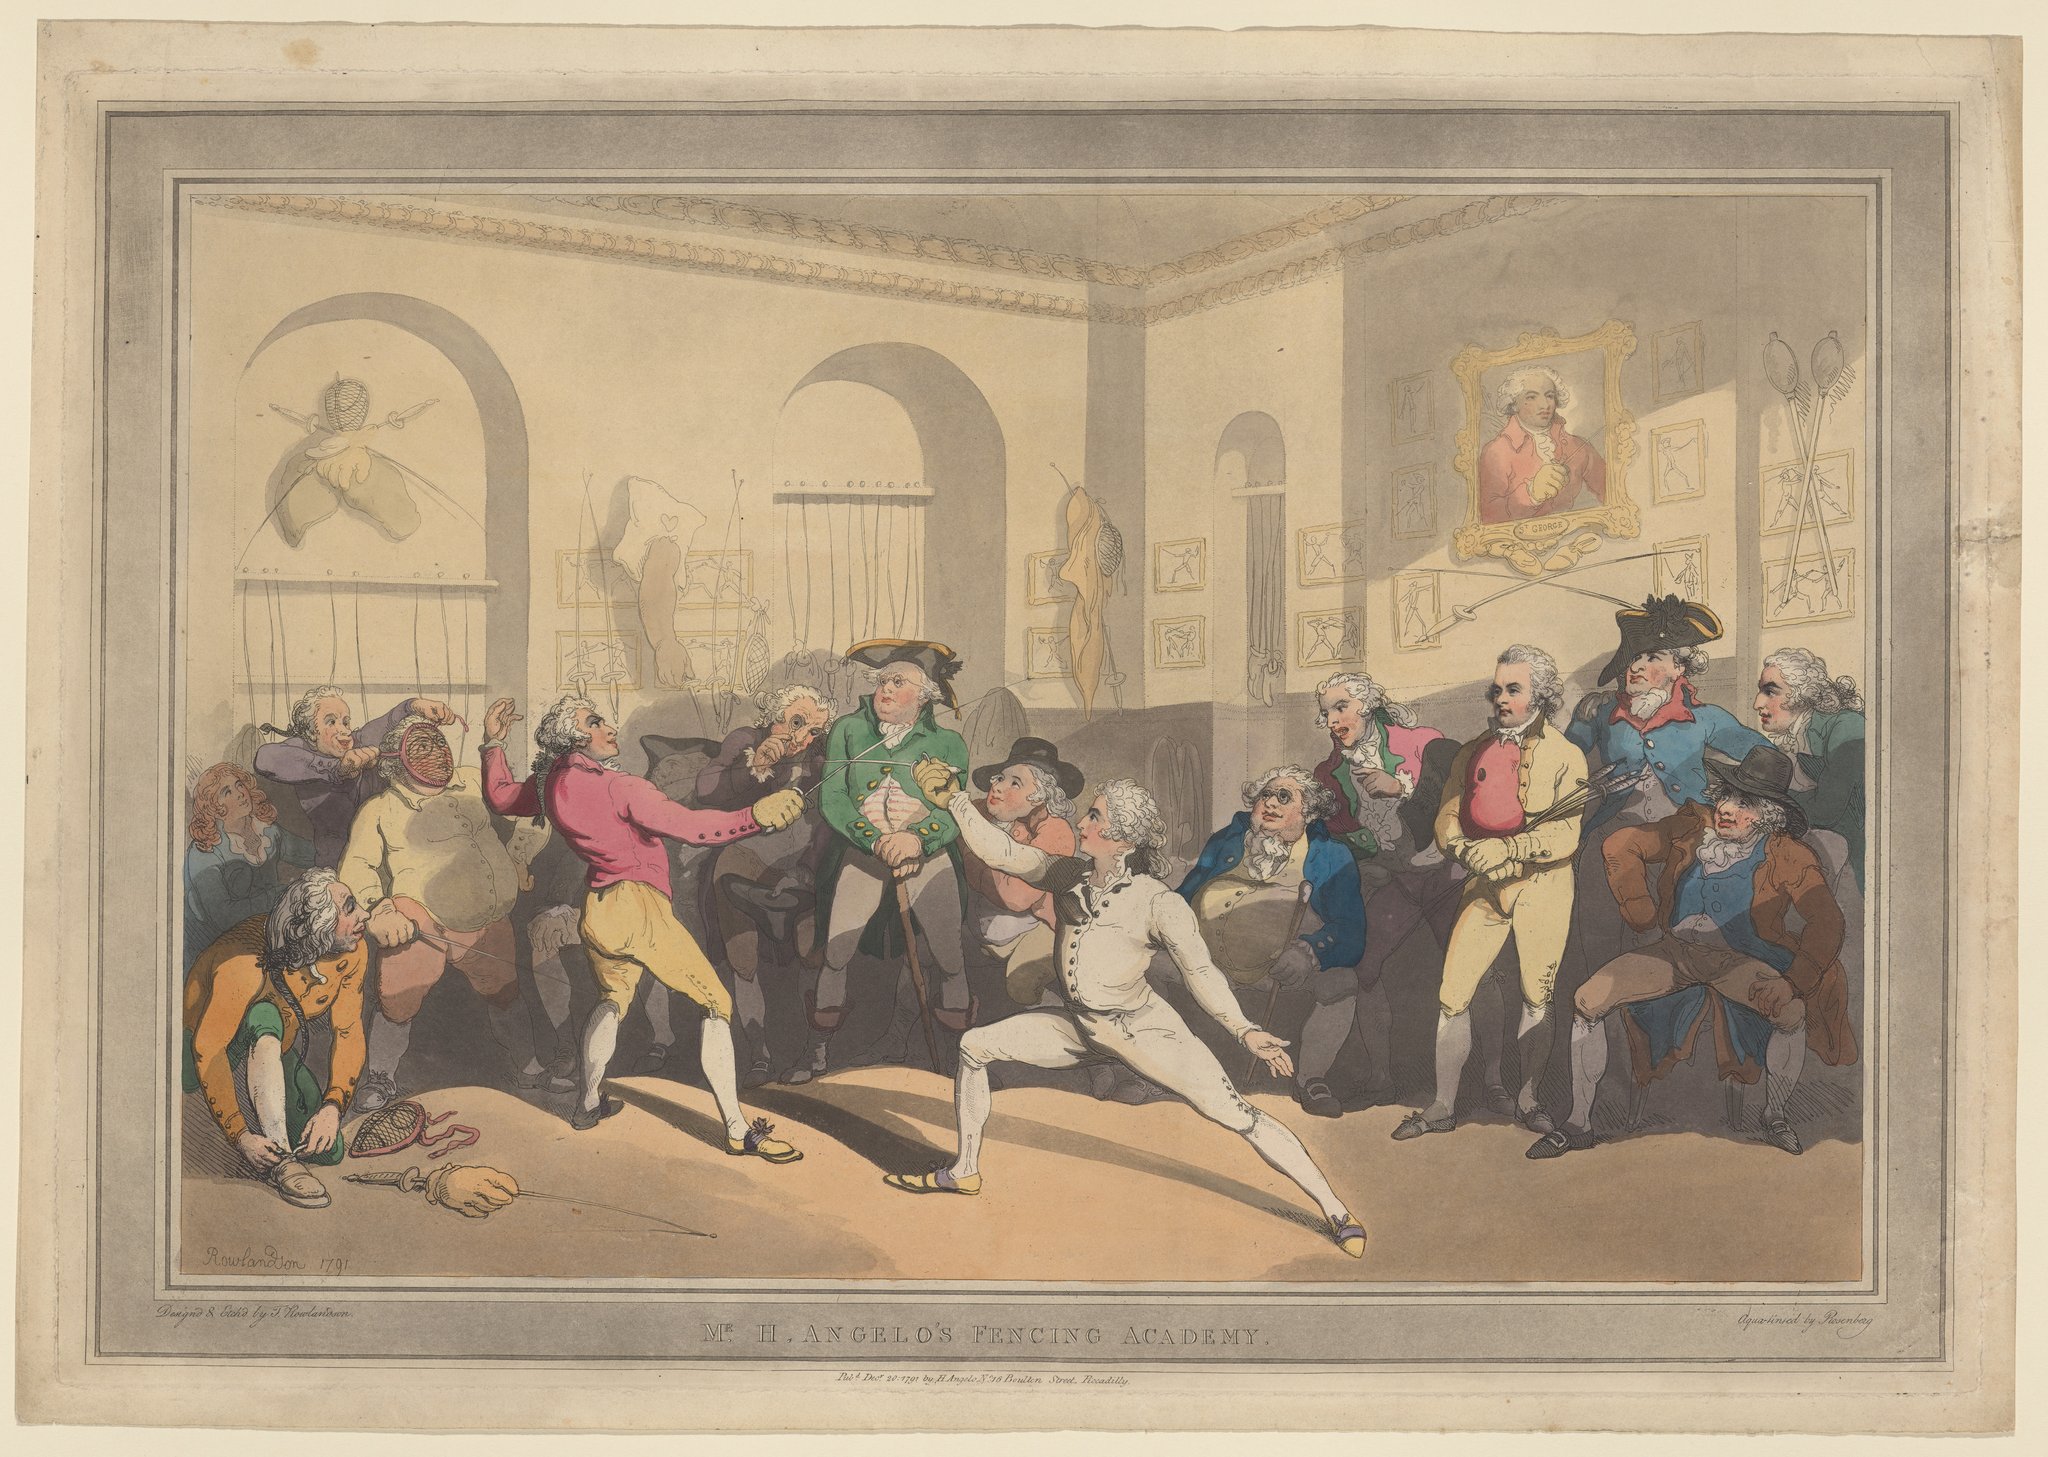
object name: print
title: Mr. H. Angelo's Fencing Academy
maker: thomas rowlandson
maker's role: artist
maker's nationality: british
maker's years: 1757-1827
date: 1791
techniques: aquatint, etching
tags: fencing